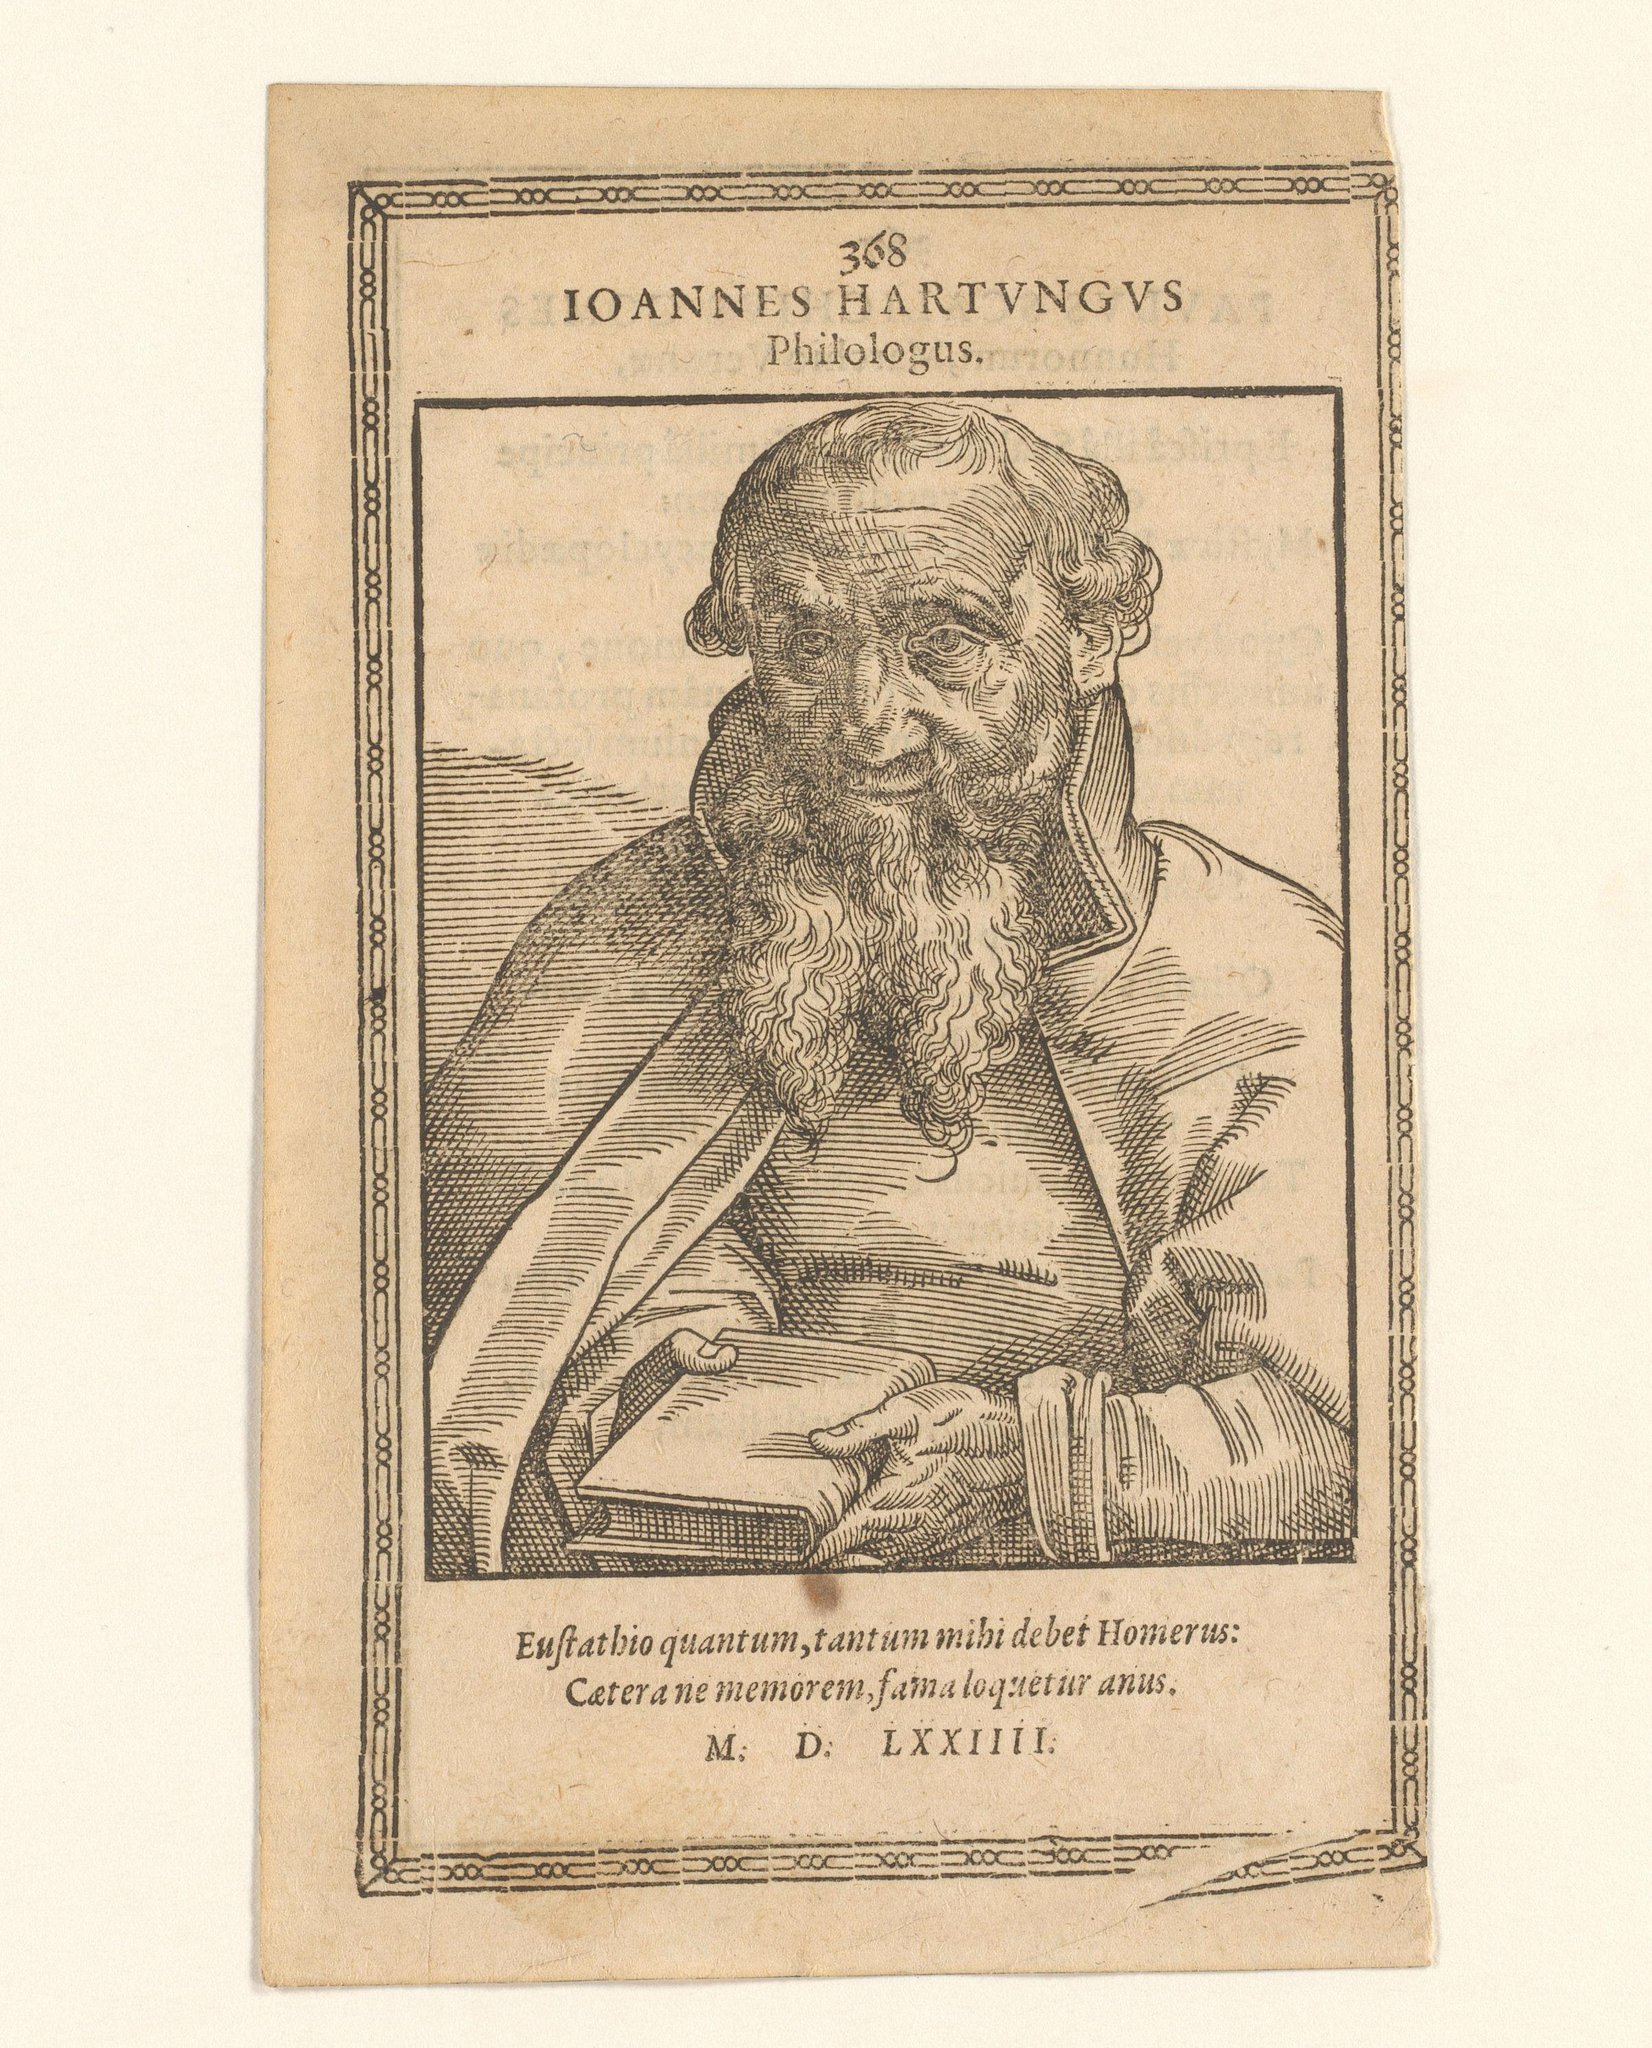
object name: print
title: Portret van Johann Hartung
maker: bernhard jobin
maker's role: printer, publisher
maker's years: 1545-1593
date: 1590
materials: paper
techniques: letterpress printing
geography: straatsburg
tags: historical persons, portrait of a writer, book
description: Prent uit: Reusner, Nikolaus. Icones sive imagines virorum literis illustrium (...). Straatsburg: Bernhard Jobin, 1590, p. 368. Prent voor het eerst verschenen in de eerste editie van 1587. Prent mogelijk ook gebruikt in latere publicaties.